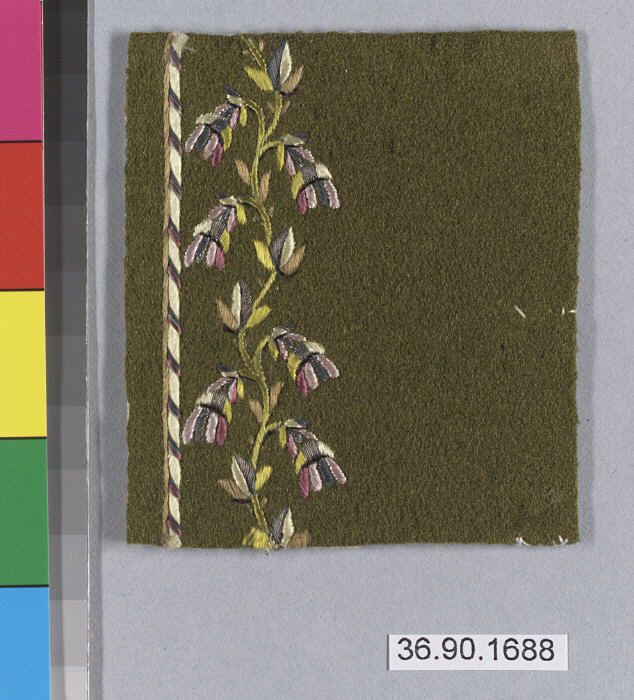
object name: sample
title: Embroidery sample for a man’s suit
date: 1785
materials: metal thread, silk, wool